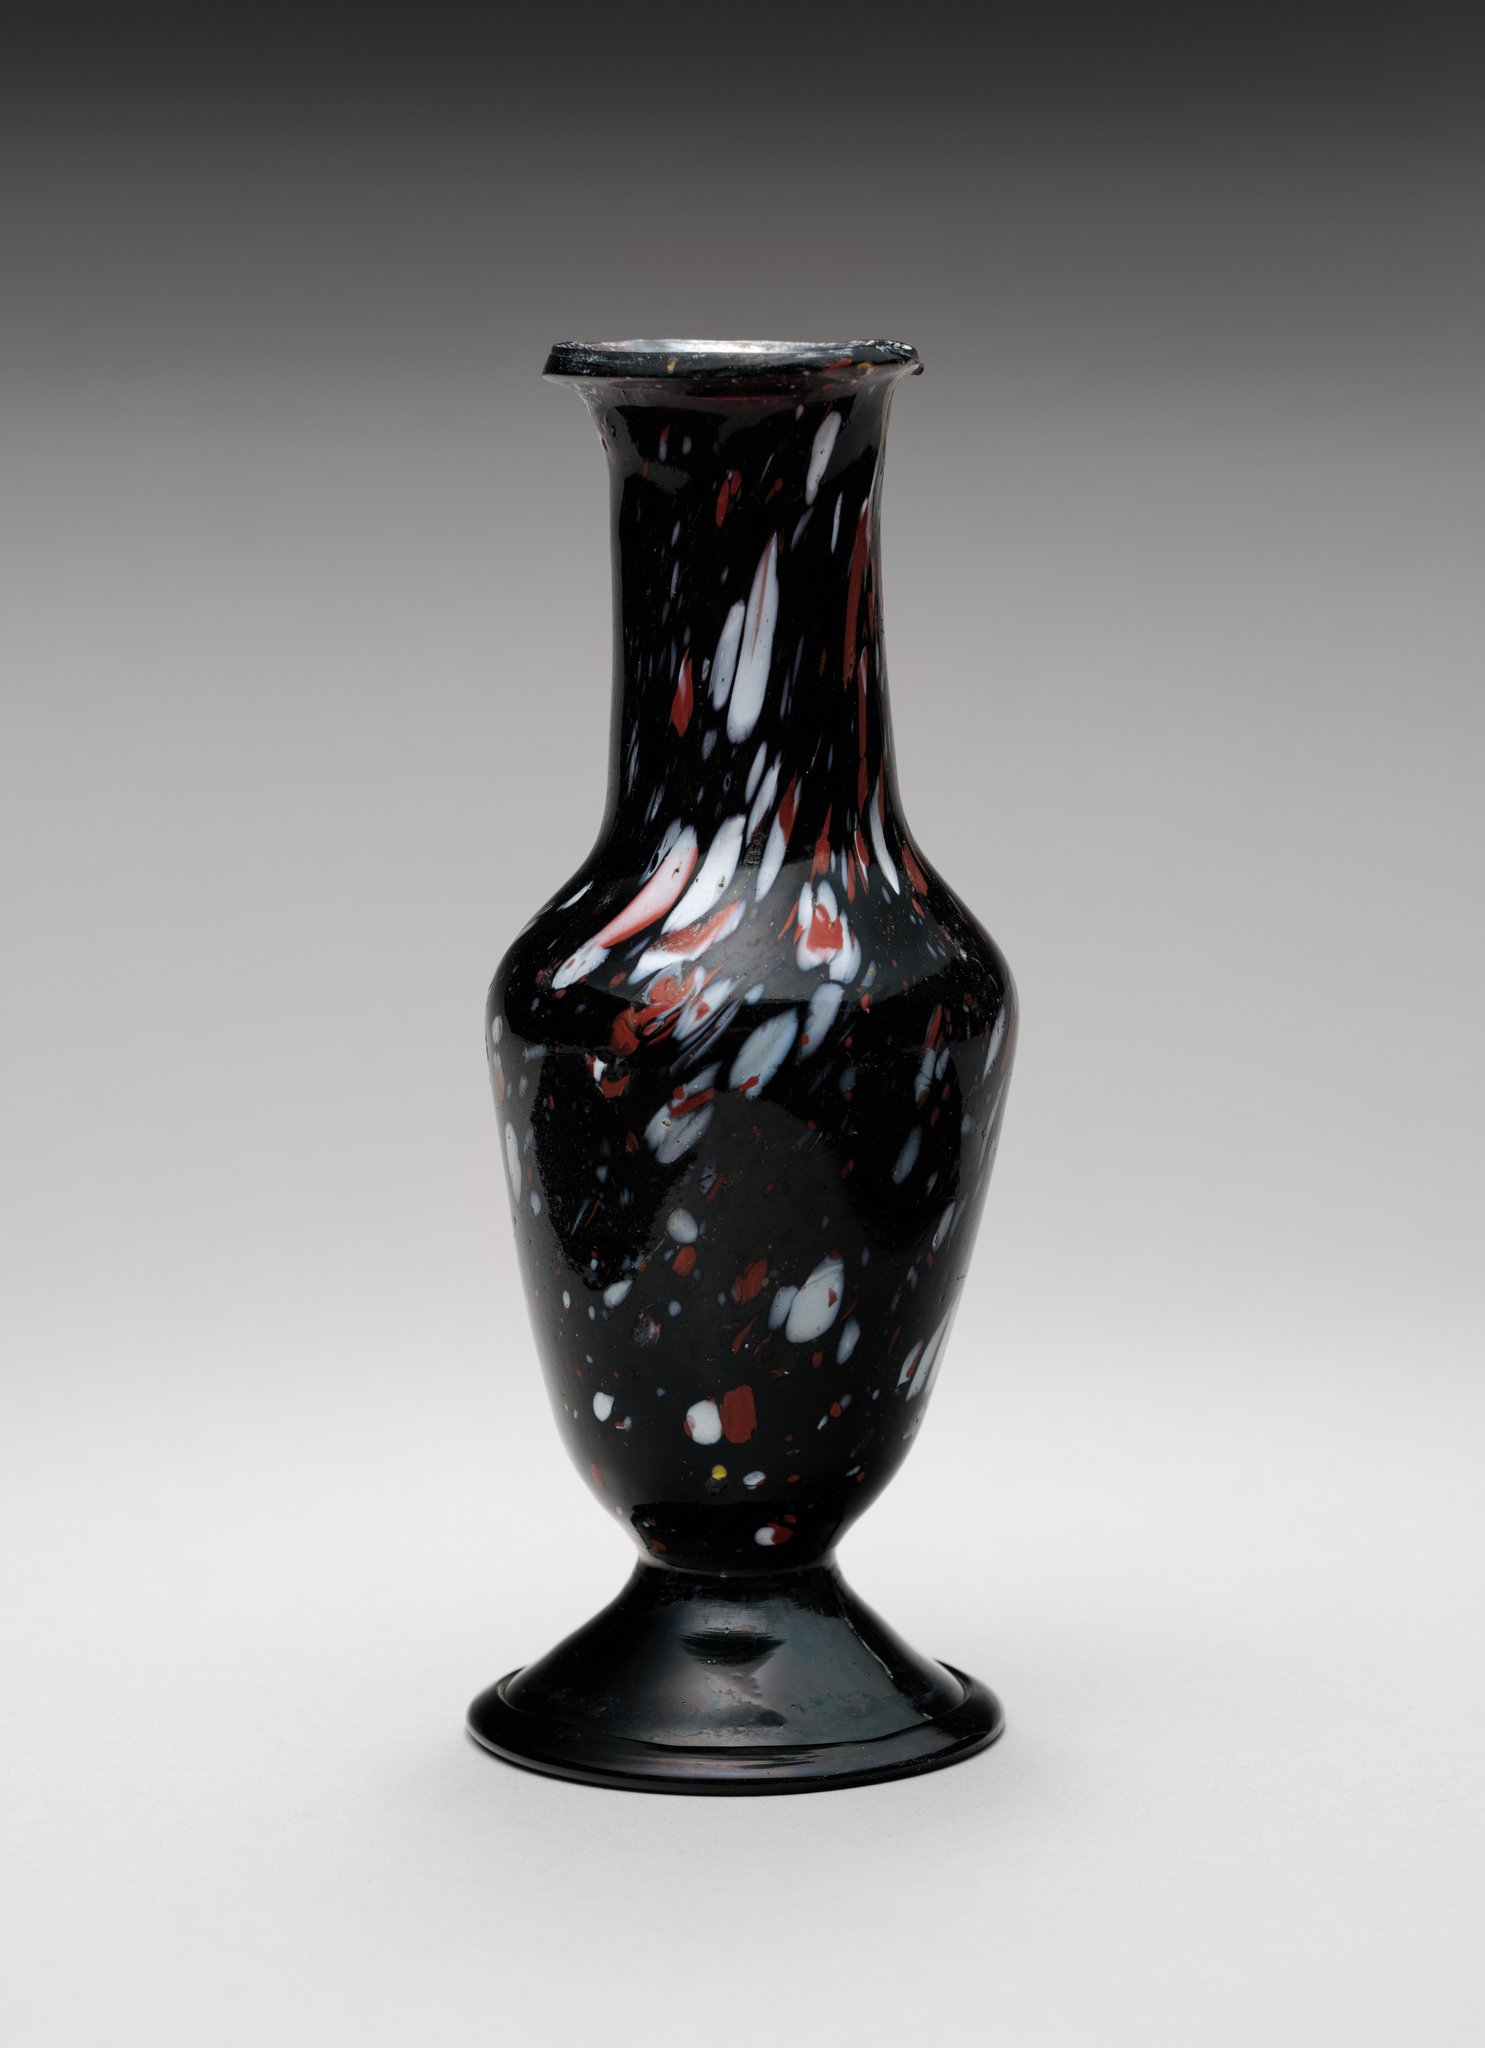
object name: vase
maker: miotti family workshop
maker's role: maker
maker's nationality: italian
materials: glass